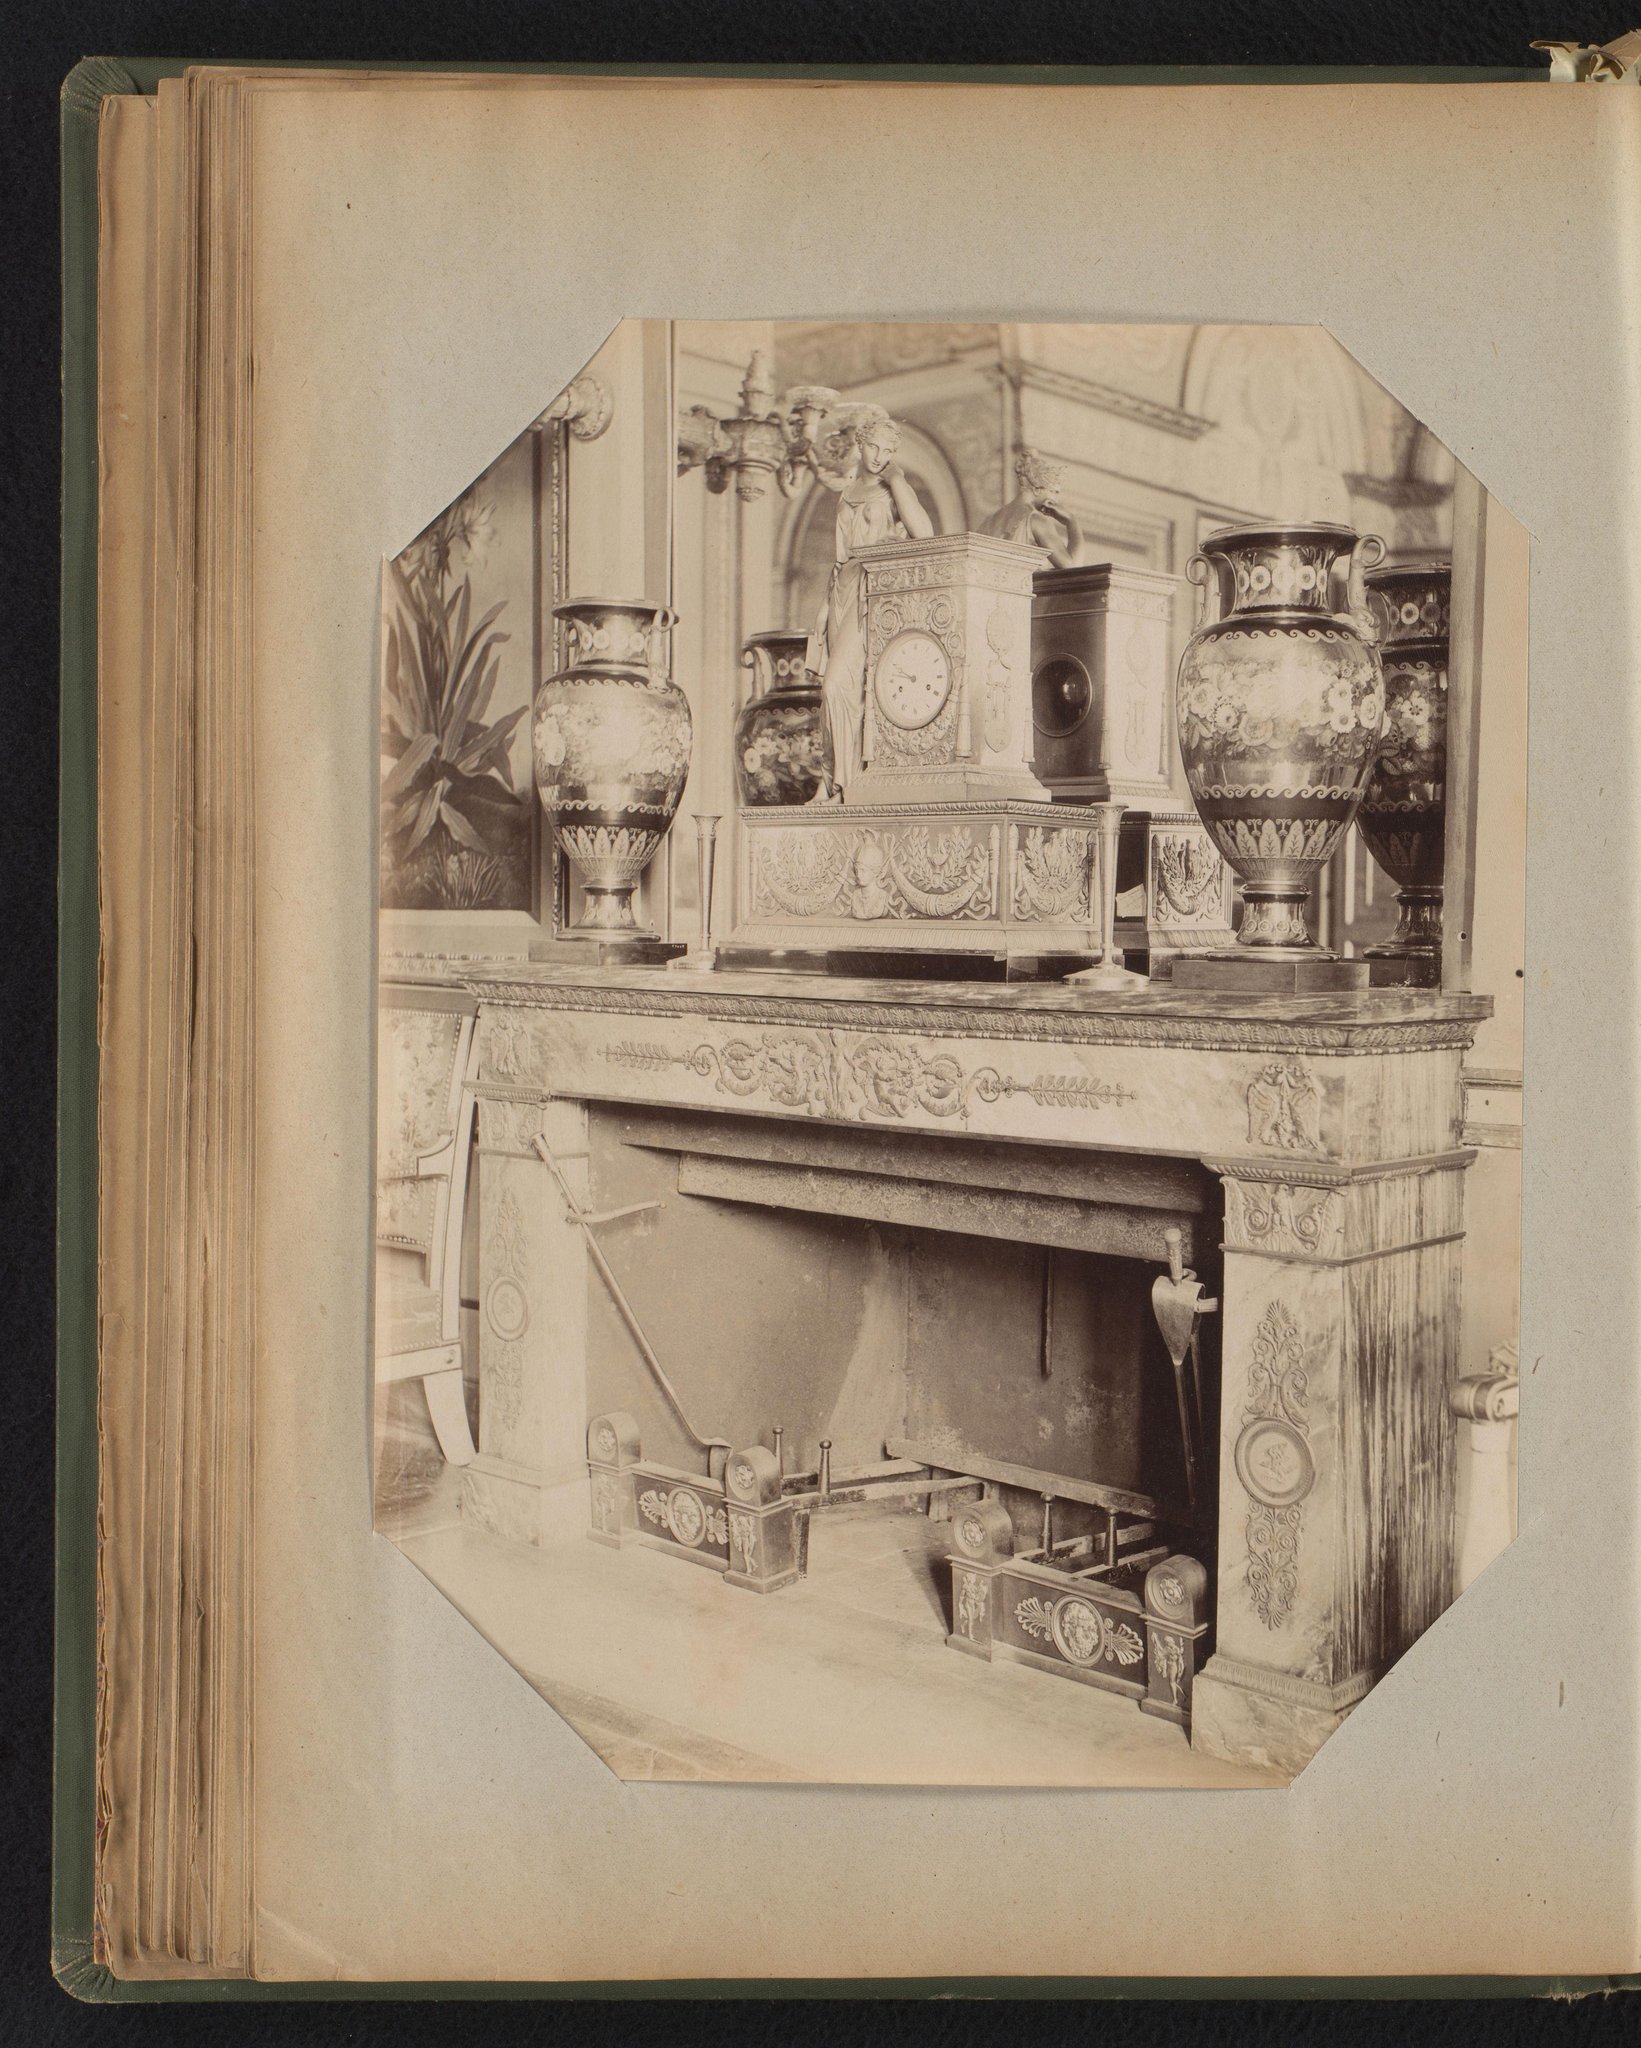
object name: photograph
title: Gedecoreerde schouw met daarop een driedelig mantelstuk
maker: Anonymous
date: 1860-1900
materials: paper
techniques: albumen print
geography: france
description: De pendule op de schouw is voorzien van een breed voetstuk met daarop een vrouw figuur. Naast de pendule staan twee met bloemen beschilderde vazen.